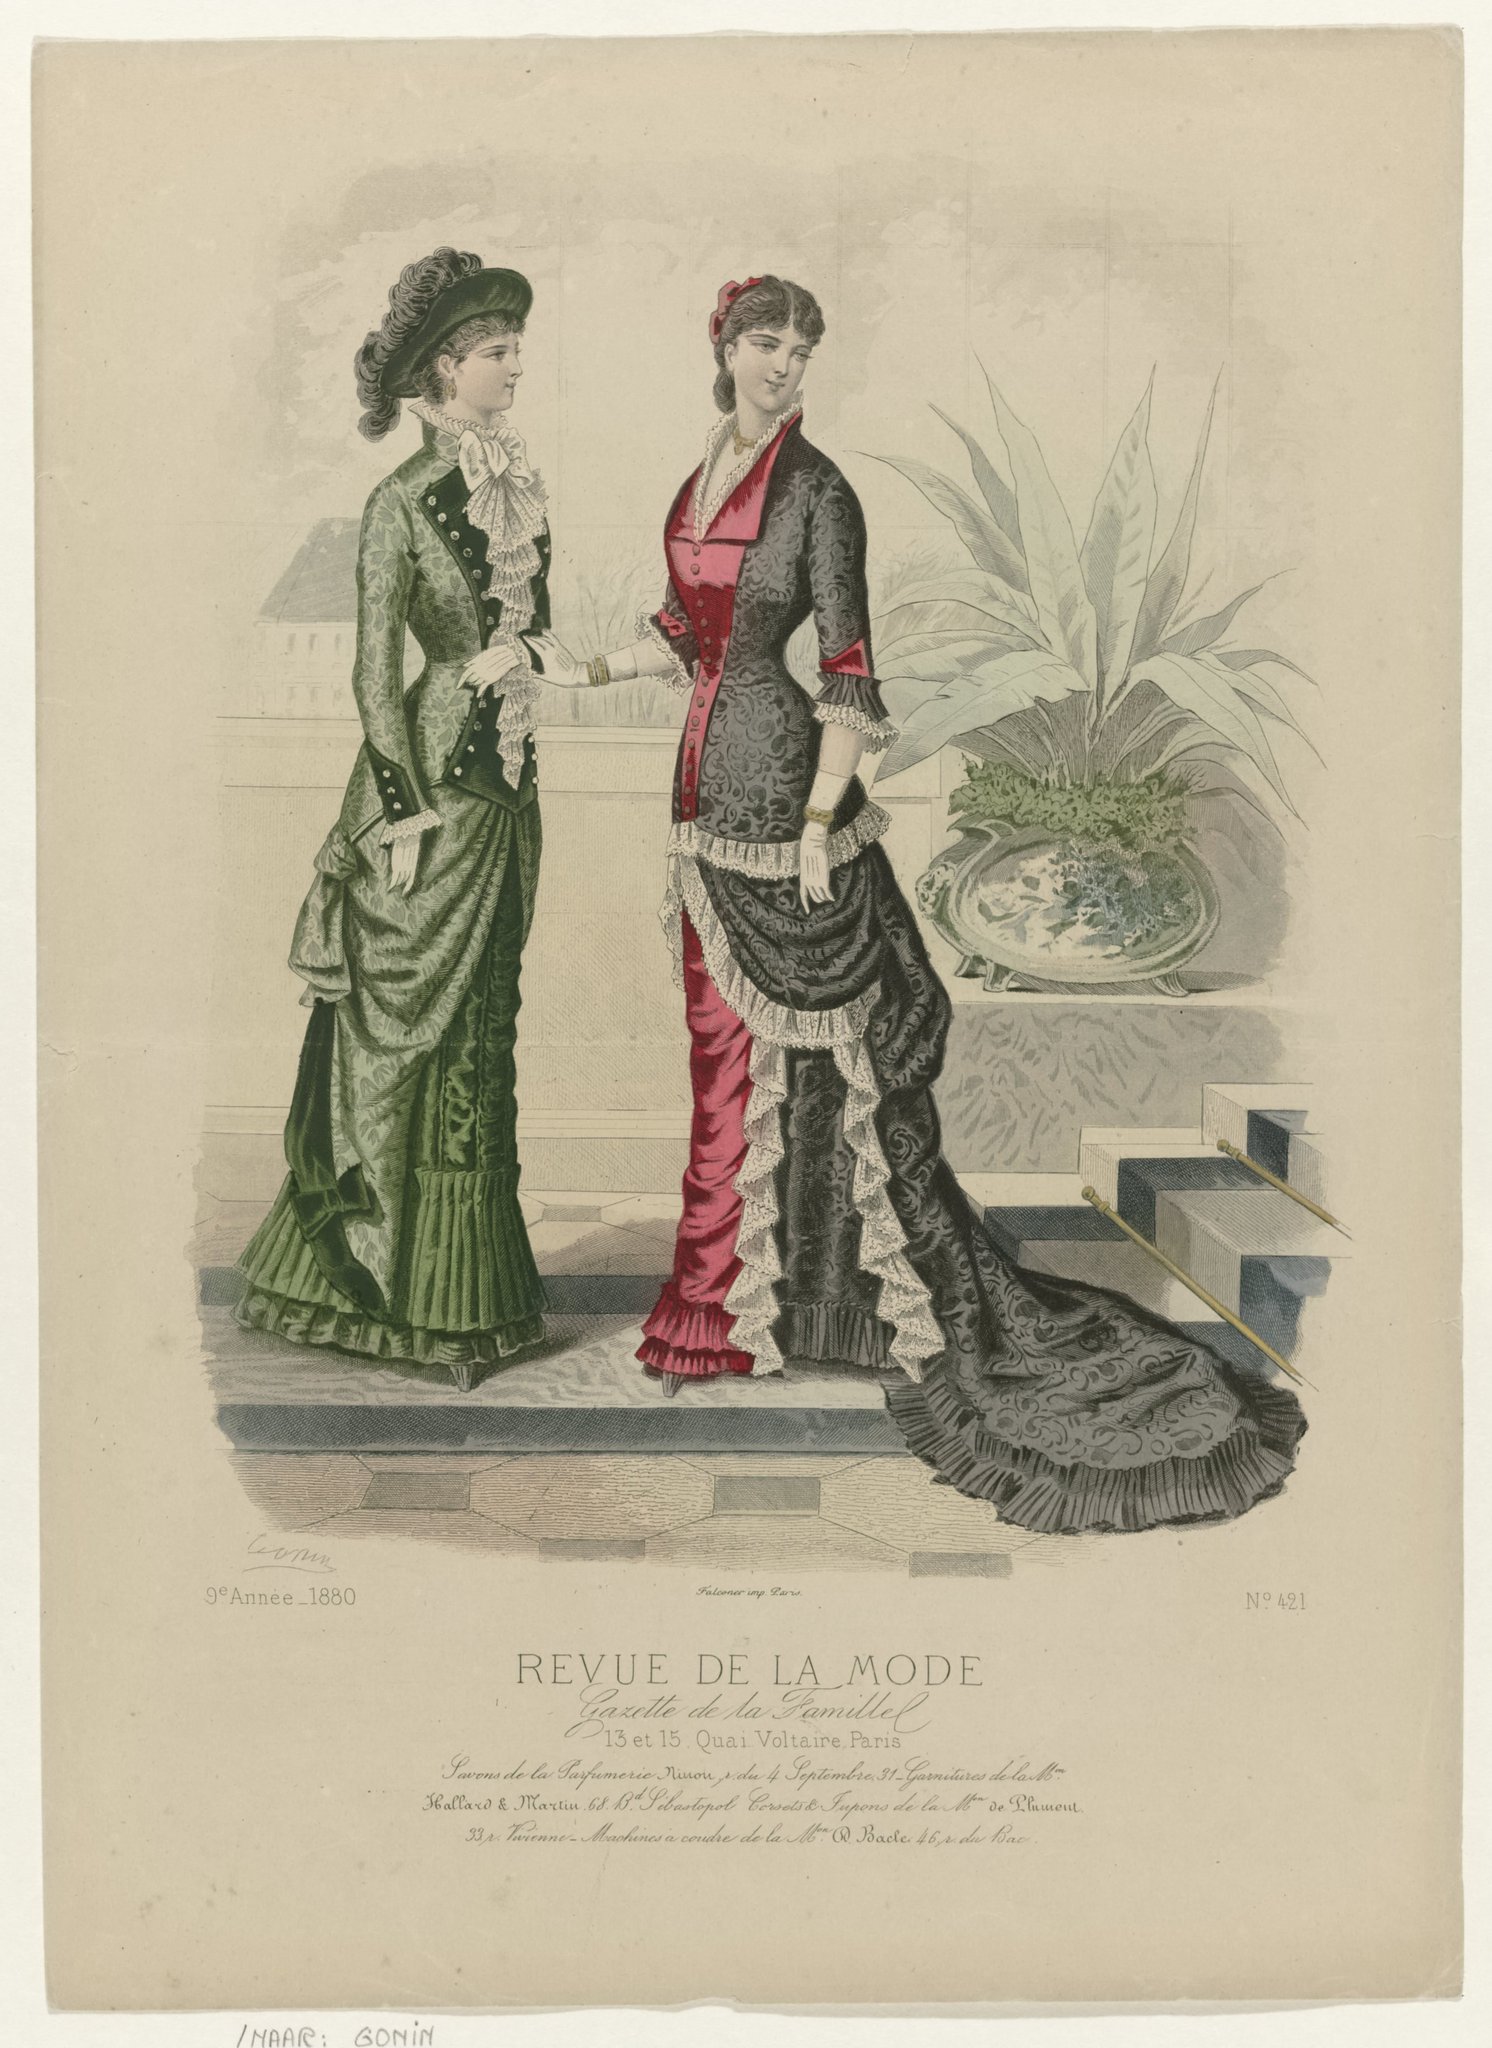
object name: fashion print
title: Revue de la Mode, Gazette de la Famille, dimanche 25 janvier 1880, 9e année, No. 421: Savons de la Parfumeri (...)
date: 1880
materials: paper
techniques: engraving, hand coloring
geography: paris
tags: ear-rings (+ women's clothes), dress, gown: evening dress (+ women's clothes), gloves, mittens (long gloves) (+ women's clothes), fashion plates, head-gear: hat (+ women's clothes), skirt (+ women's clothes), bracelet, wristlet (+ women's clothes), necklace (+ women's clothes), garden vase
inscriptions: caption: ‘Savons de la Parfumerie Ninon. r. du 4 Septembre 31_ Garnitures de la M.on Hallard & Martin 68 Bd Sébastopol Corsets & Jupons de la M.on de Plument. 33,r. Vivienne_ Machines à coudre de la M.on D. Bacle, 46. r. du Bac.’, address: ‘13 et 15, Quai Voltaire, Paris’, title: ‘REVUE DE LA MODE / Gazette de la Famille’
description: Twee vrouwen op een terras met tuinvaas. Links: 'toilette de ville'. Rechts: japon voor een soirée en receptie. Onder de voorstelling enkele regels reclametekst voor verschillende producten. Prent uit het modetijdschrift Revue de la Mode (1872-1913). Uitgebreide beschrijving van de kleding op pagina 38 "PLANCHE COLORIÉE" .